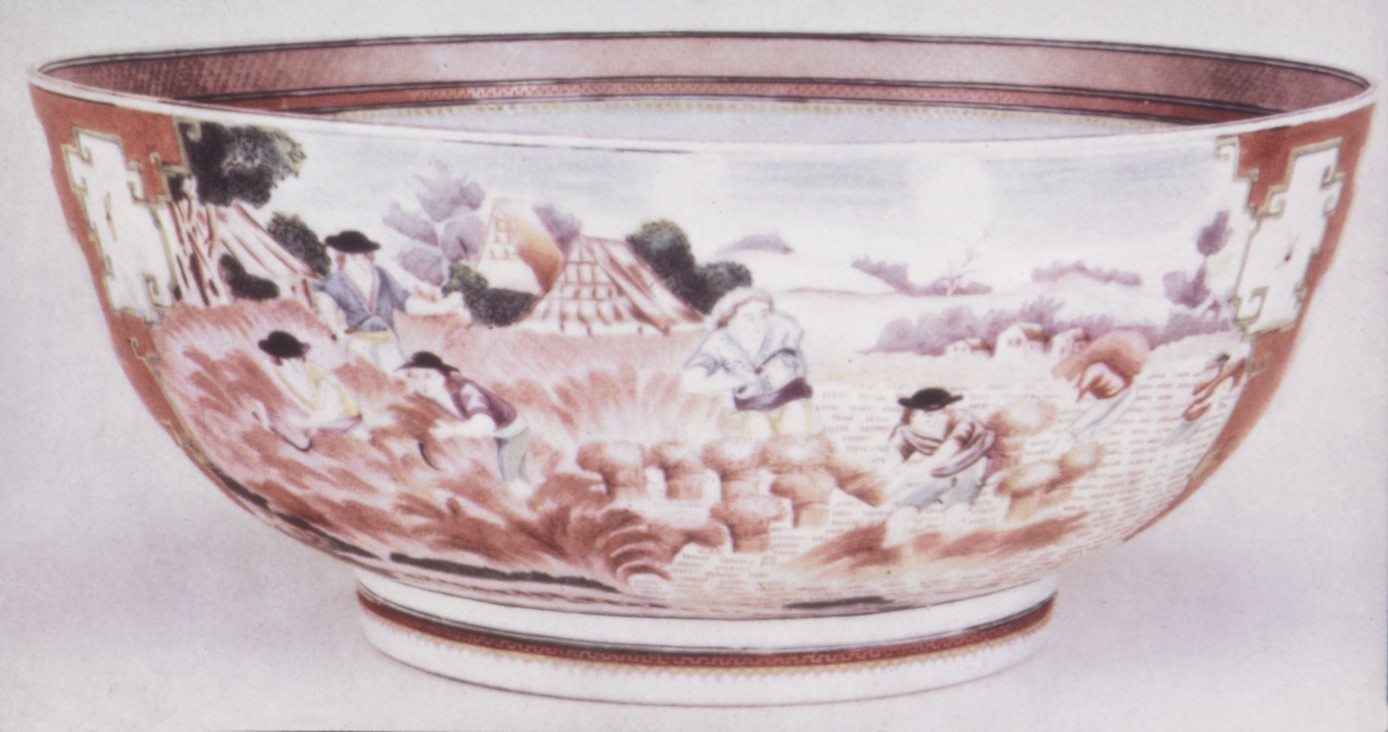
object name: punch bowl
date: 1785-1800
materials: hard paste porcelain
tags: men